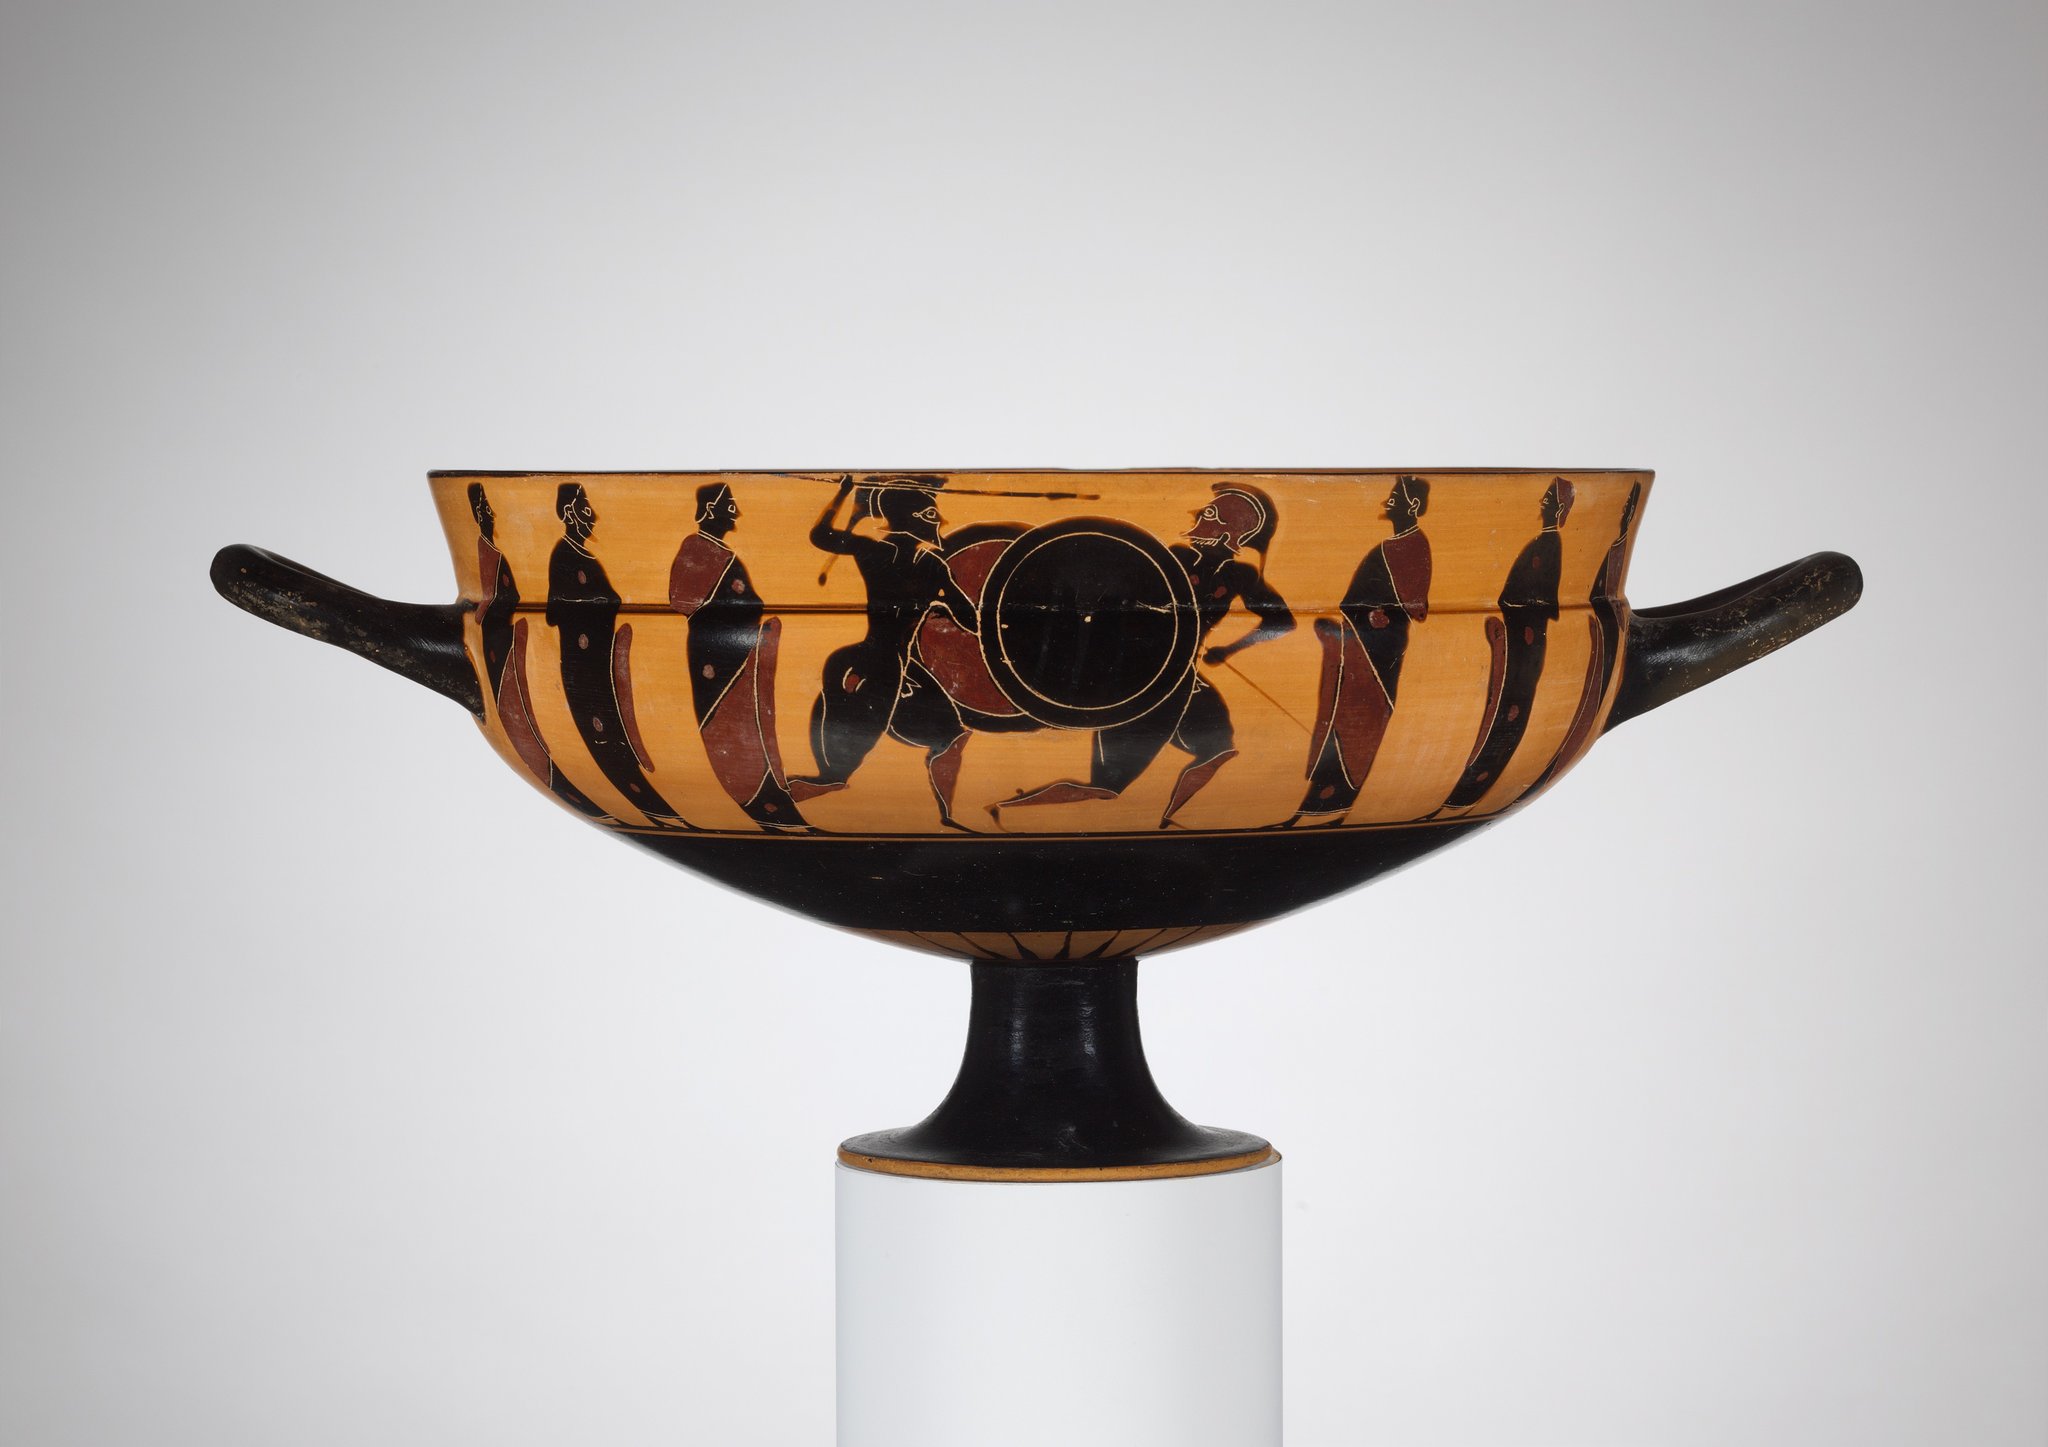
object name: kylix, siana cup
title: Terracotta kylix: Siana cup (drinking cup)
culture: greek, attic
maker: sandal painter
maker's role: artist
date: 560-550 BCE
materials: terracotta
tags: shields,spears,men,warriors